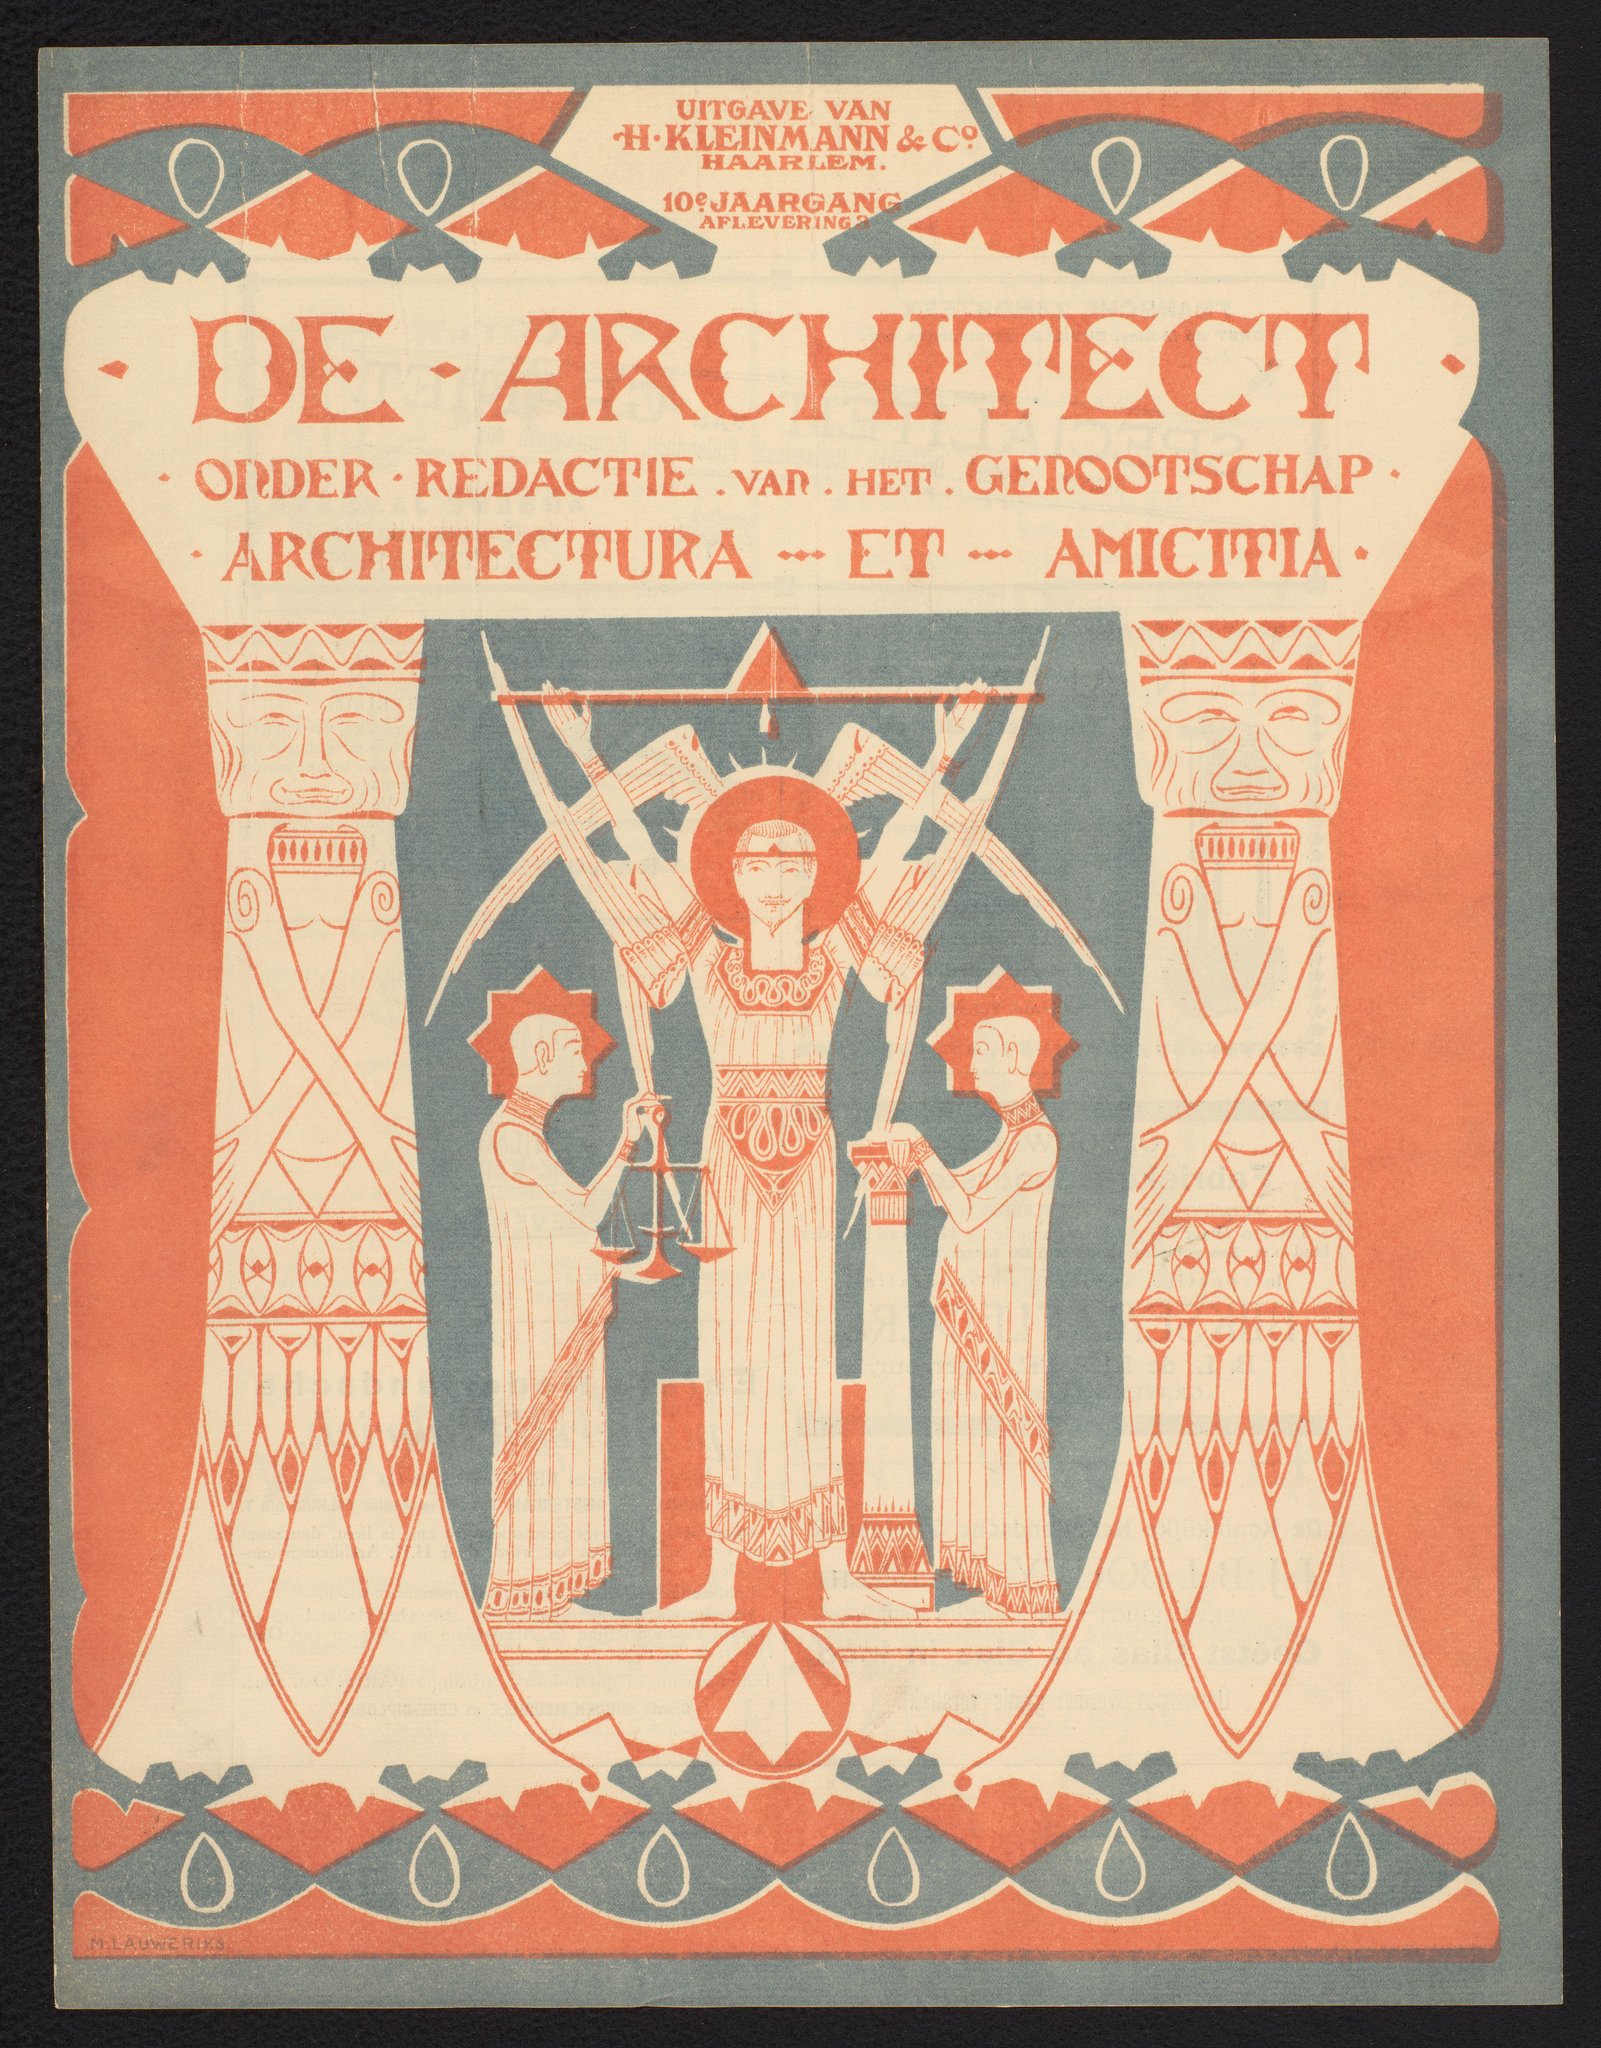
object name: print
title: Omslag voor: De architect. Plaatwerk van Architectura et Amicitia, 10 (1899), nr. 3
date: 1899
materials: paper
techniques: letterpress printing, lithograph, printing block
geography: haarlem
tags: weekly, monthly, magazine, etc., book-cover, binding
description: Dit omslag, in gebruik vanaf het tiende jaargang, werd benut tot en met de zesde aflevering van het elfde jaargang. Het omslag vervangt het omslag door K.P.C. de Bazel dat tot die tijd gebruikt werd (zie RP-P-OB-20.234).